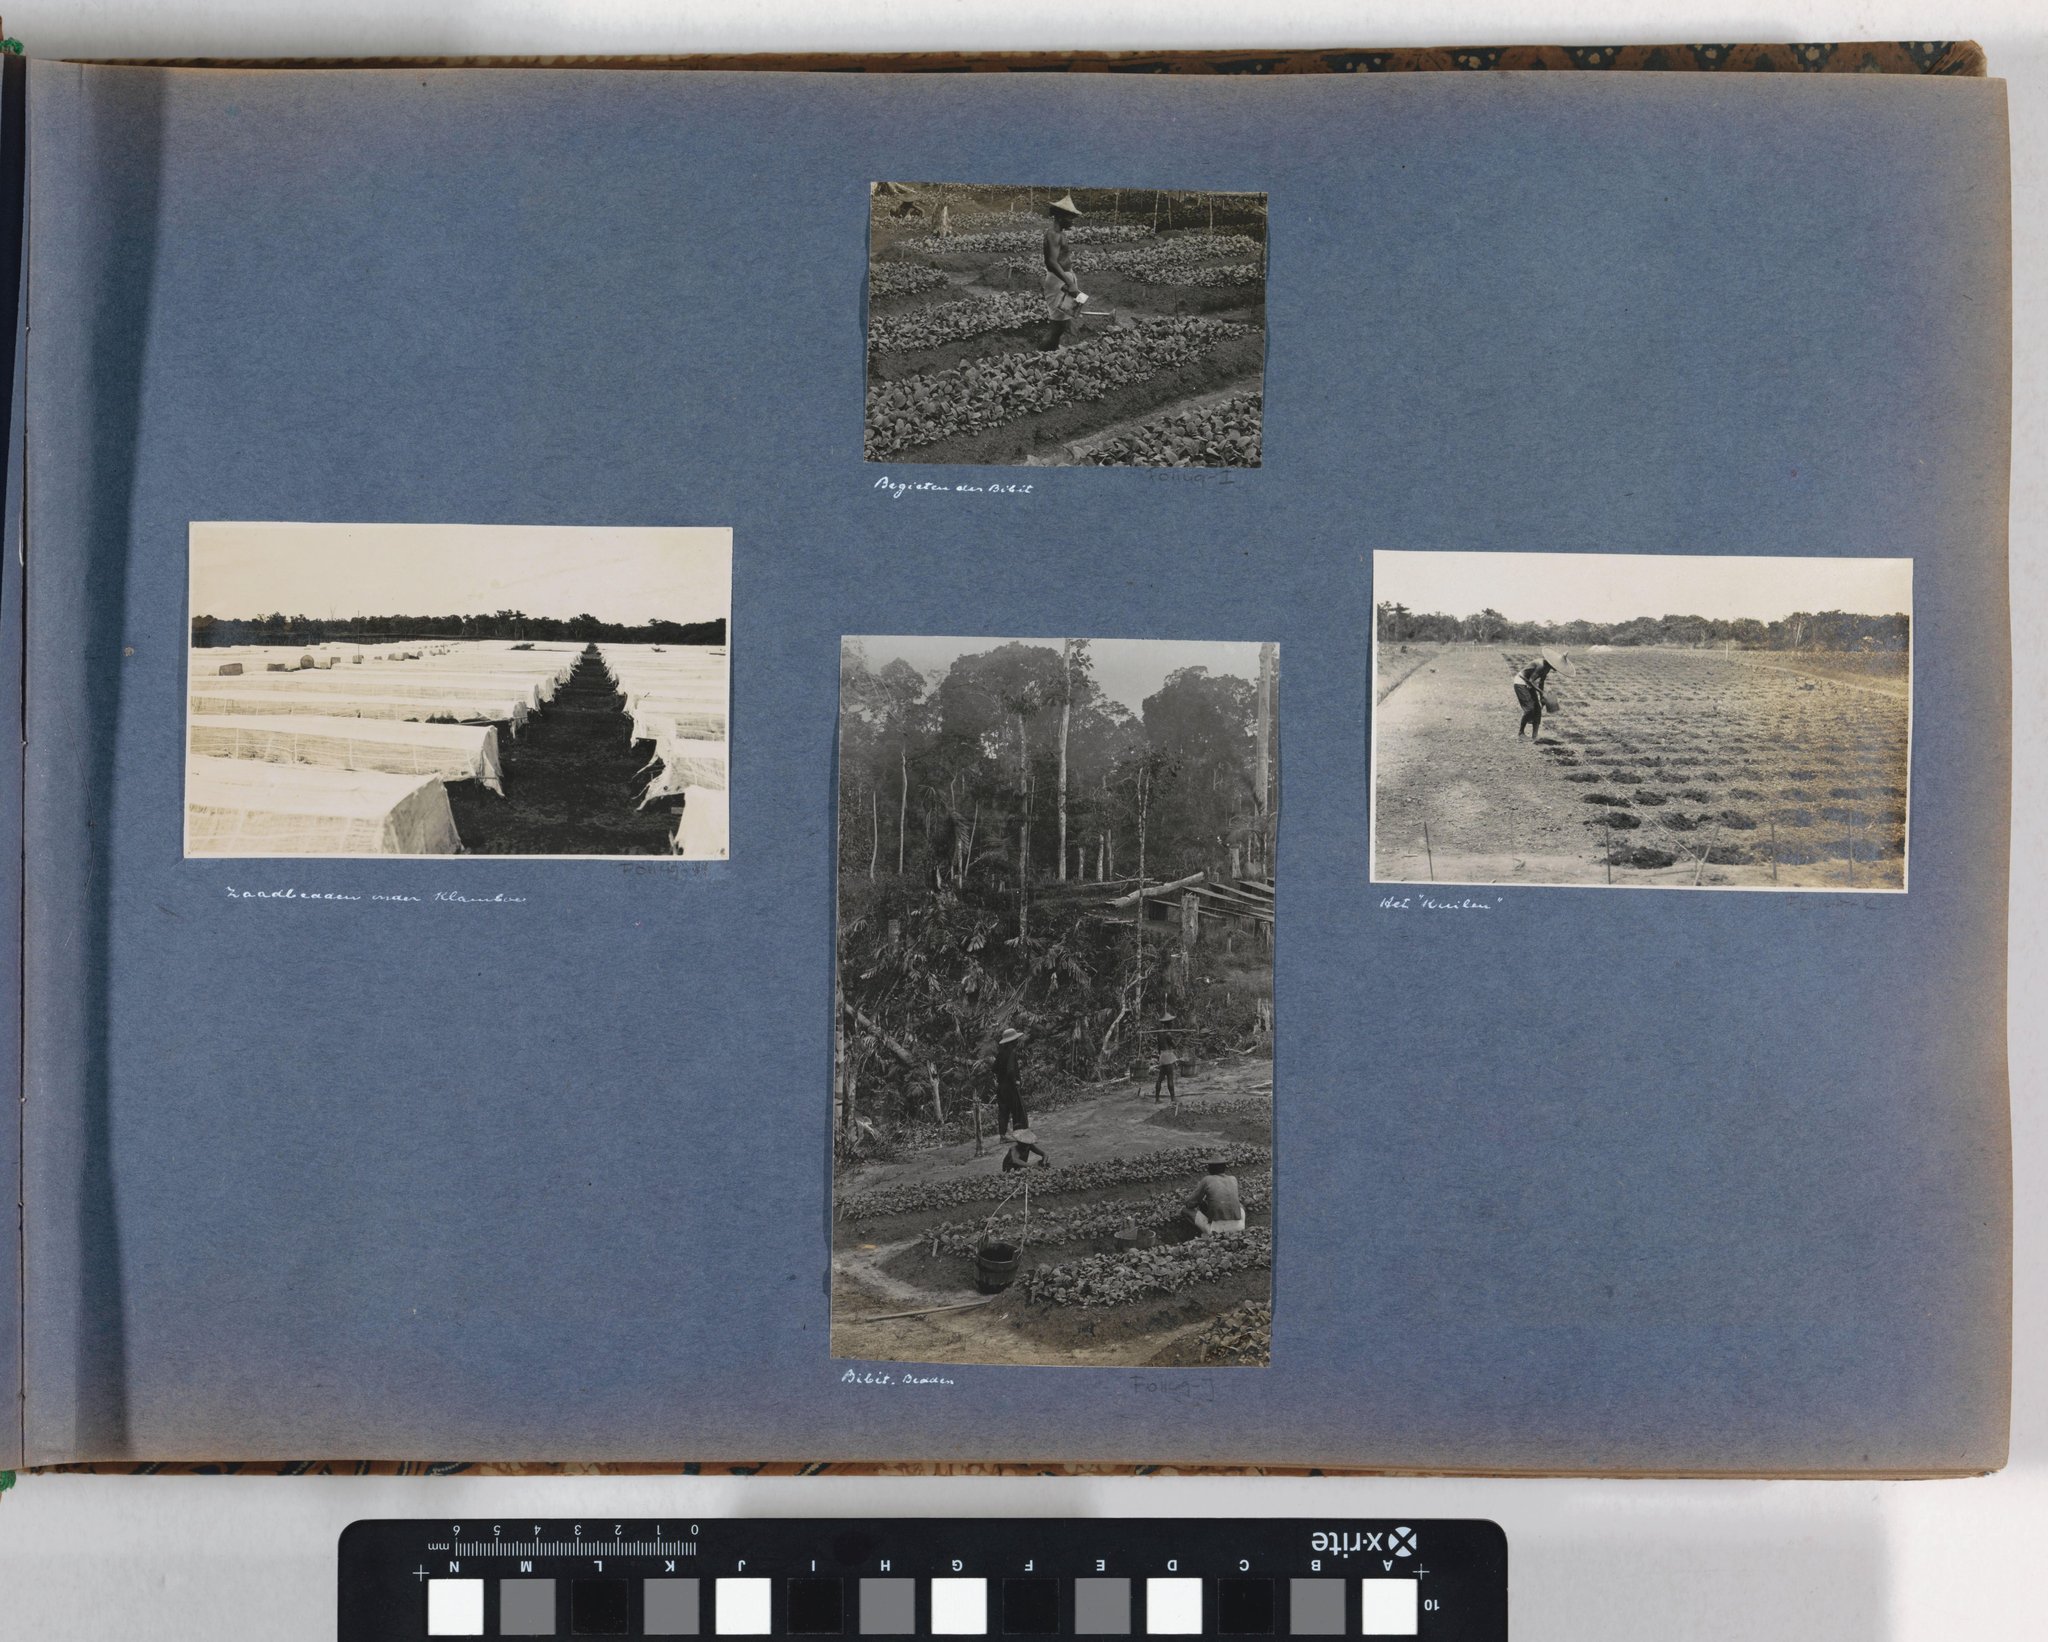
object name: album leaf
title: Mannen aan het werk met kiemplanten (bibit) op Sumatra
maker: Anonymous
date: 1900-1920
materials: paper, photographic support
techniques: gelatin silver print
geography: sumatra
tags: plantation, working class, labourers, tobacco, sumatra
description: Mogelijk gaat het om contractarbeiders. Onderdeel van reisalbum met foto's van bedrijvigheid en bezienswaardigheden op Sumatra en Java en van de reis naar en van Nederlands-Indië.